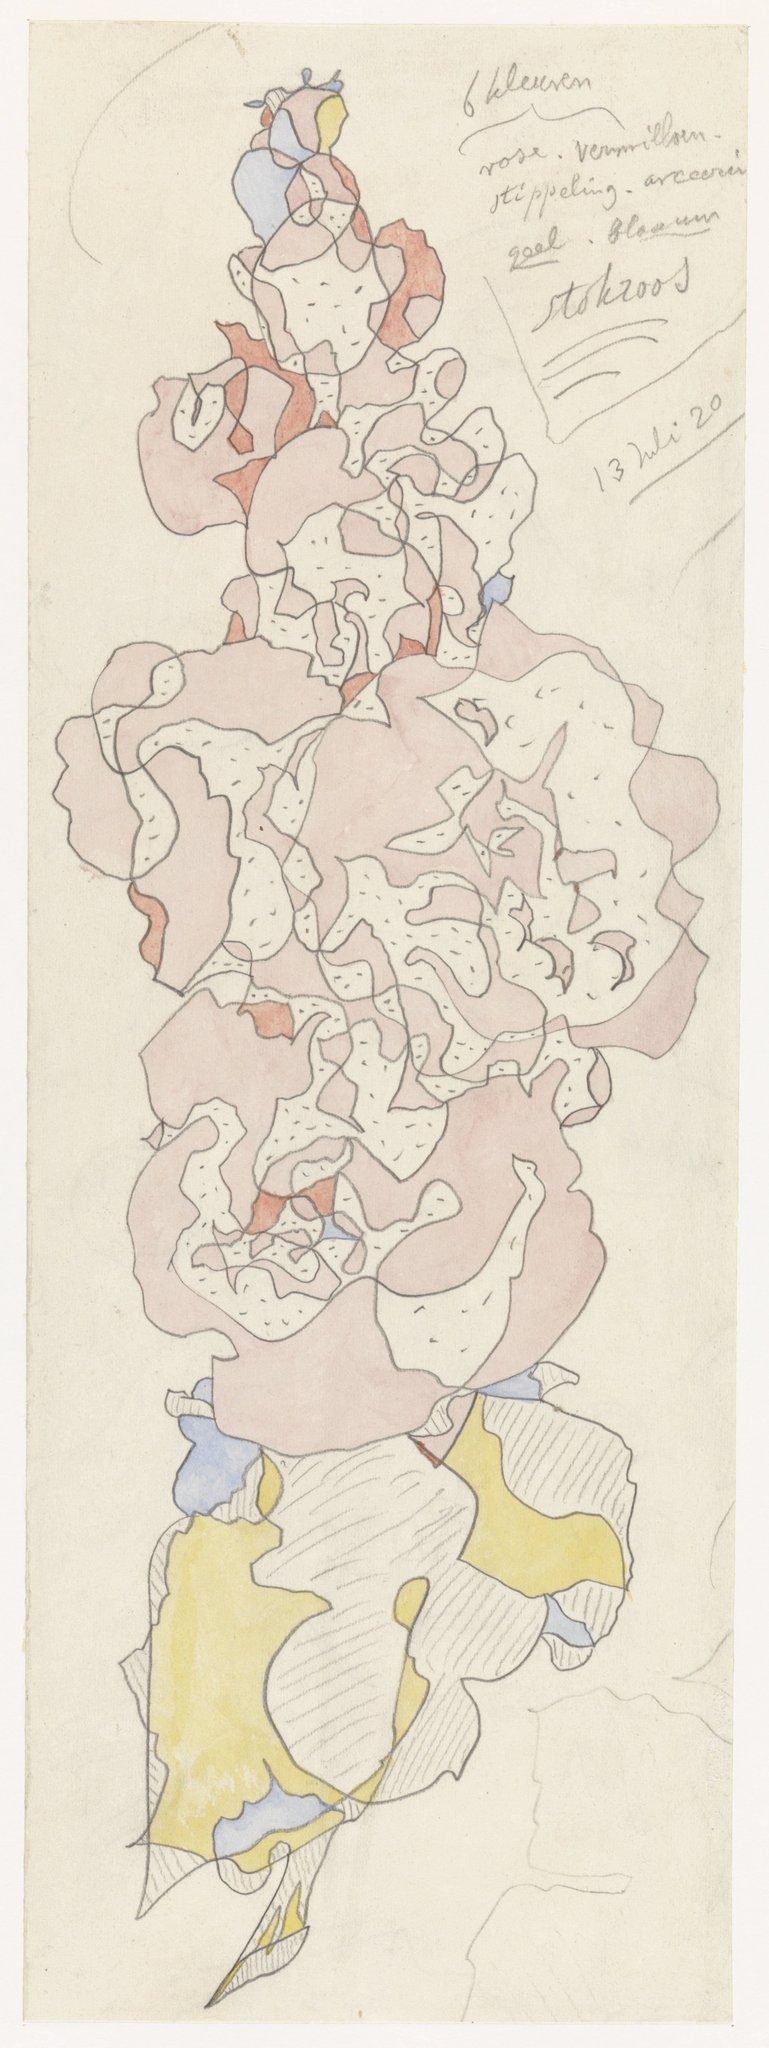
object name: drawing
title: Stokroos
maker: theo colenbrander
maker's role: draughtsman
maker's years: 1841-1930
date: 1920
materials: paper, pencil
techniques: brush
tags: flowers: hollyhock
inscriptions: date: ‘13 Juli 20’